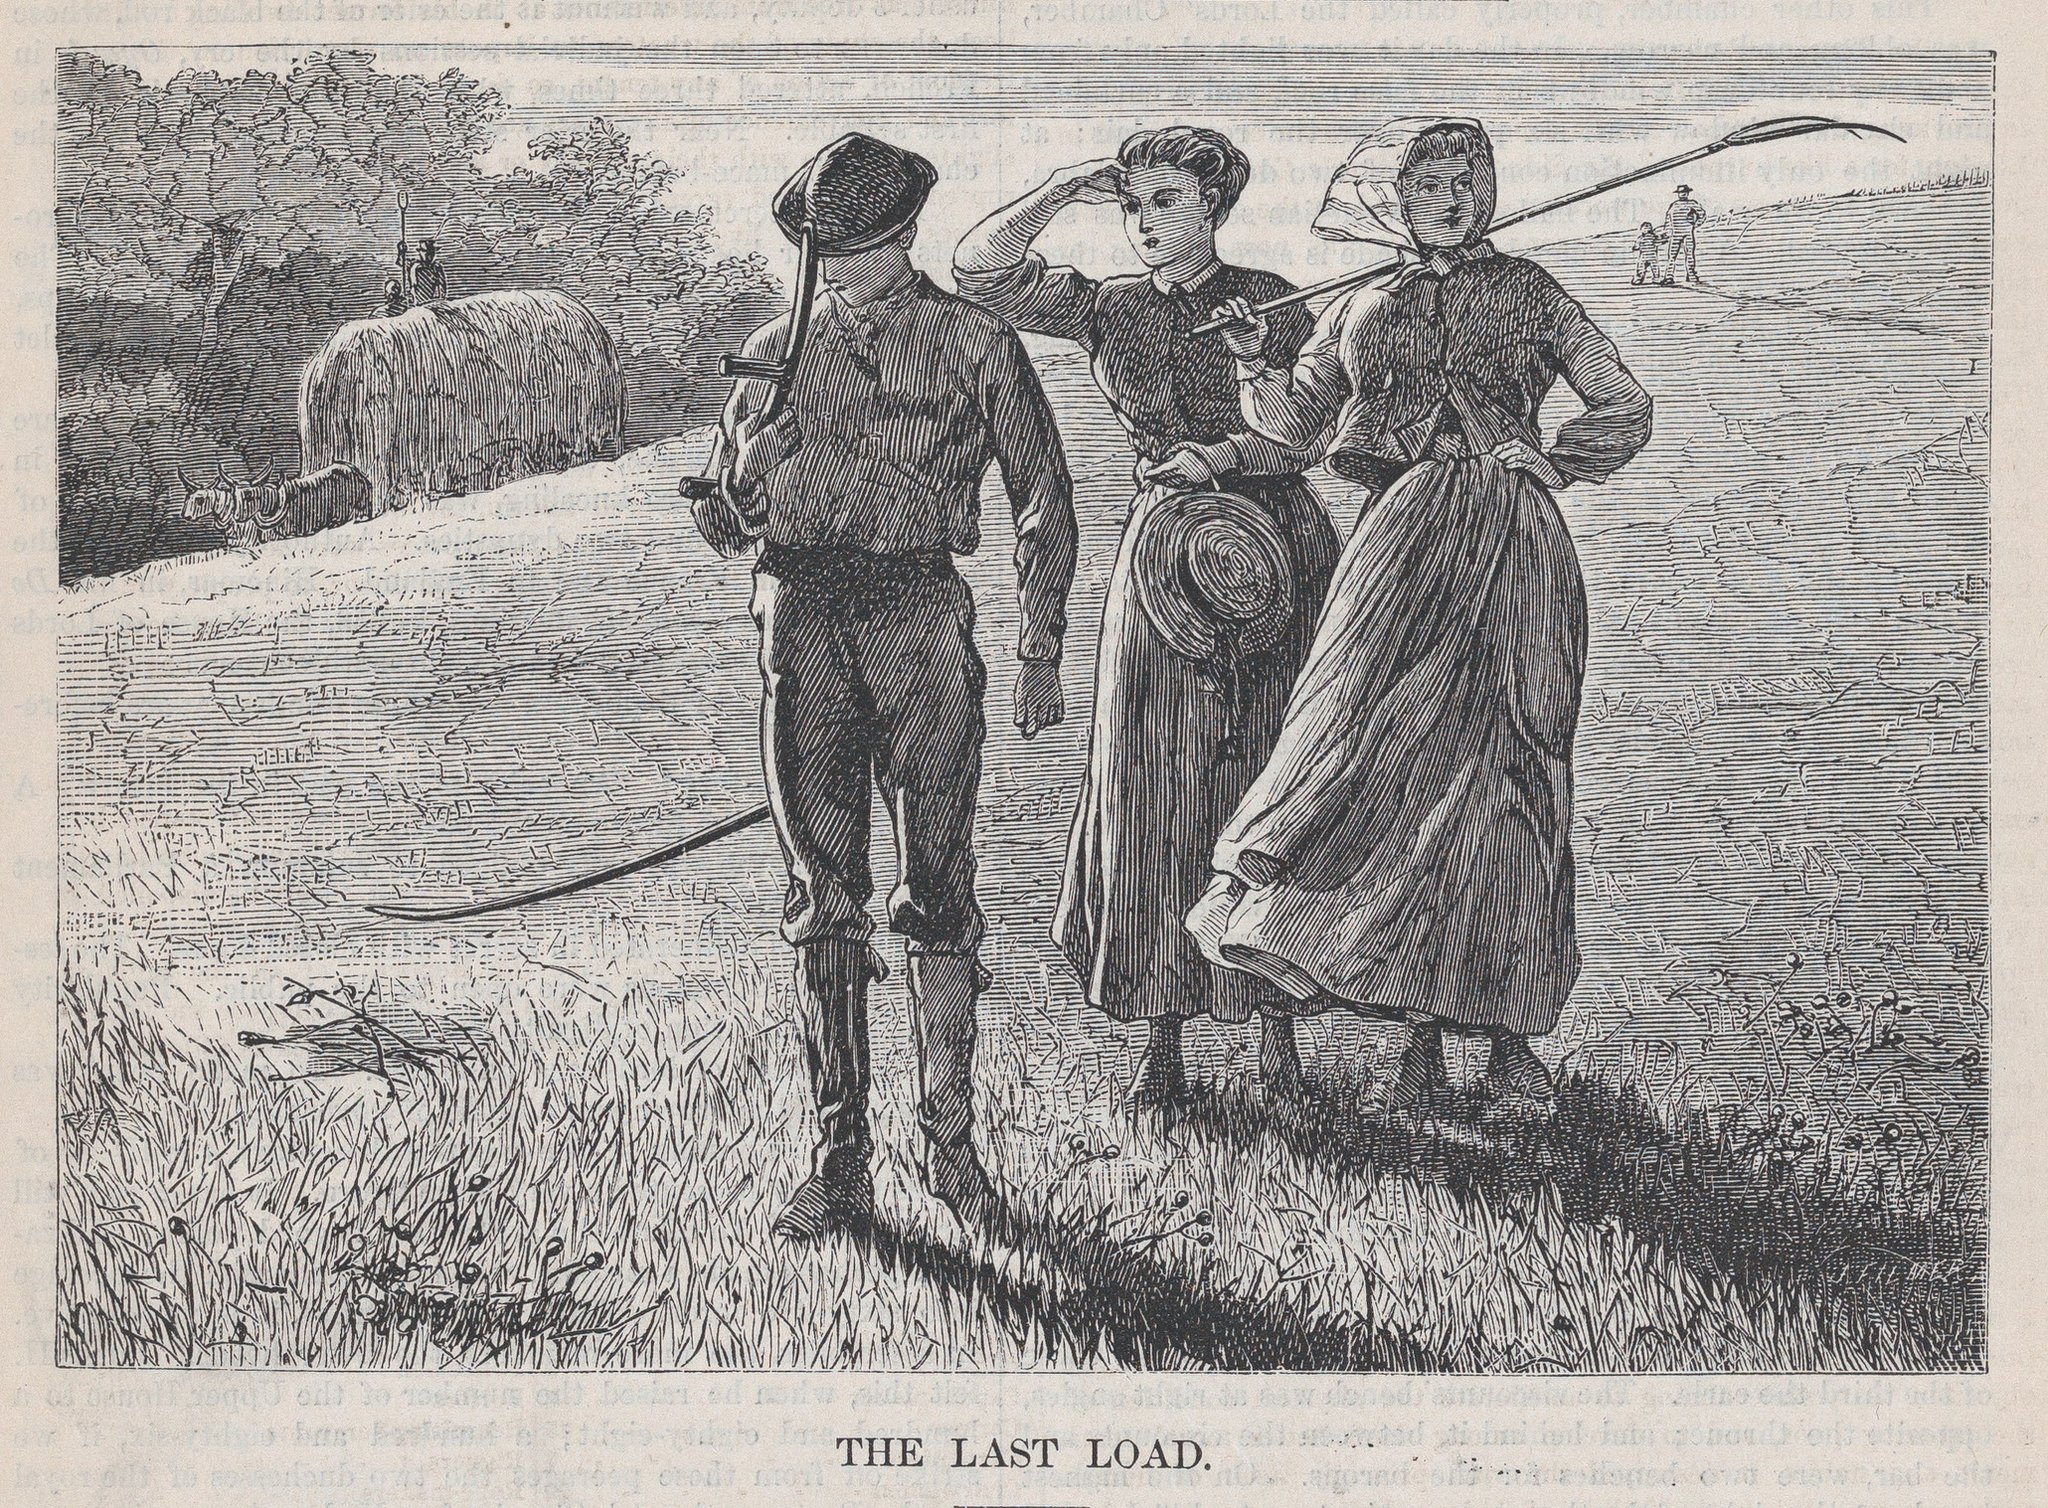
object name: print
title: The Last Load (from "Appleton's Journal," Vol. I)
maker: winslow homer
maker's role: artist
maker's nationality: american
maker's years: 1836-1910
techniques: engraving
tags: men,women